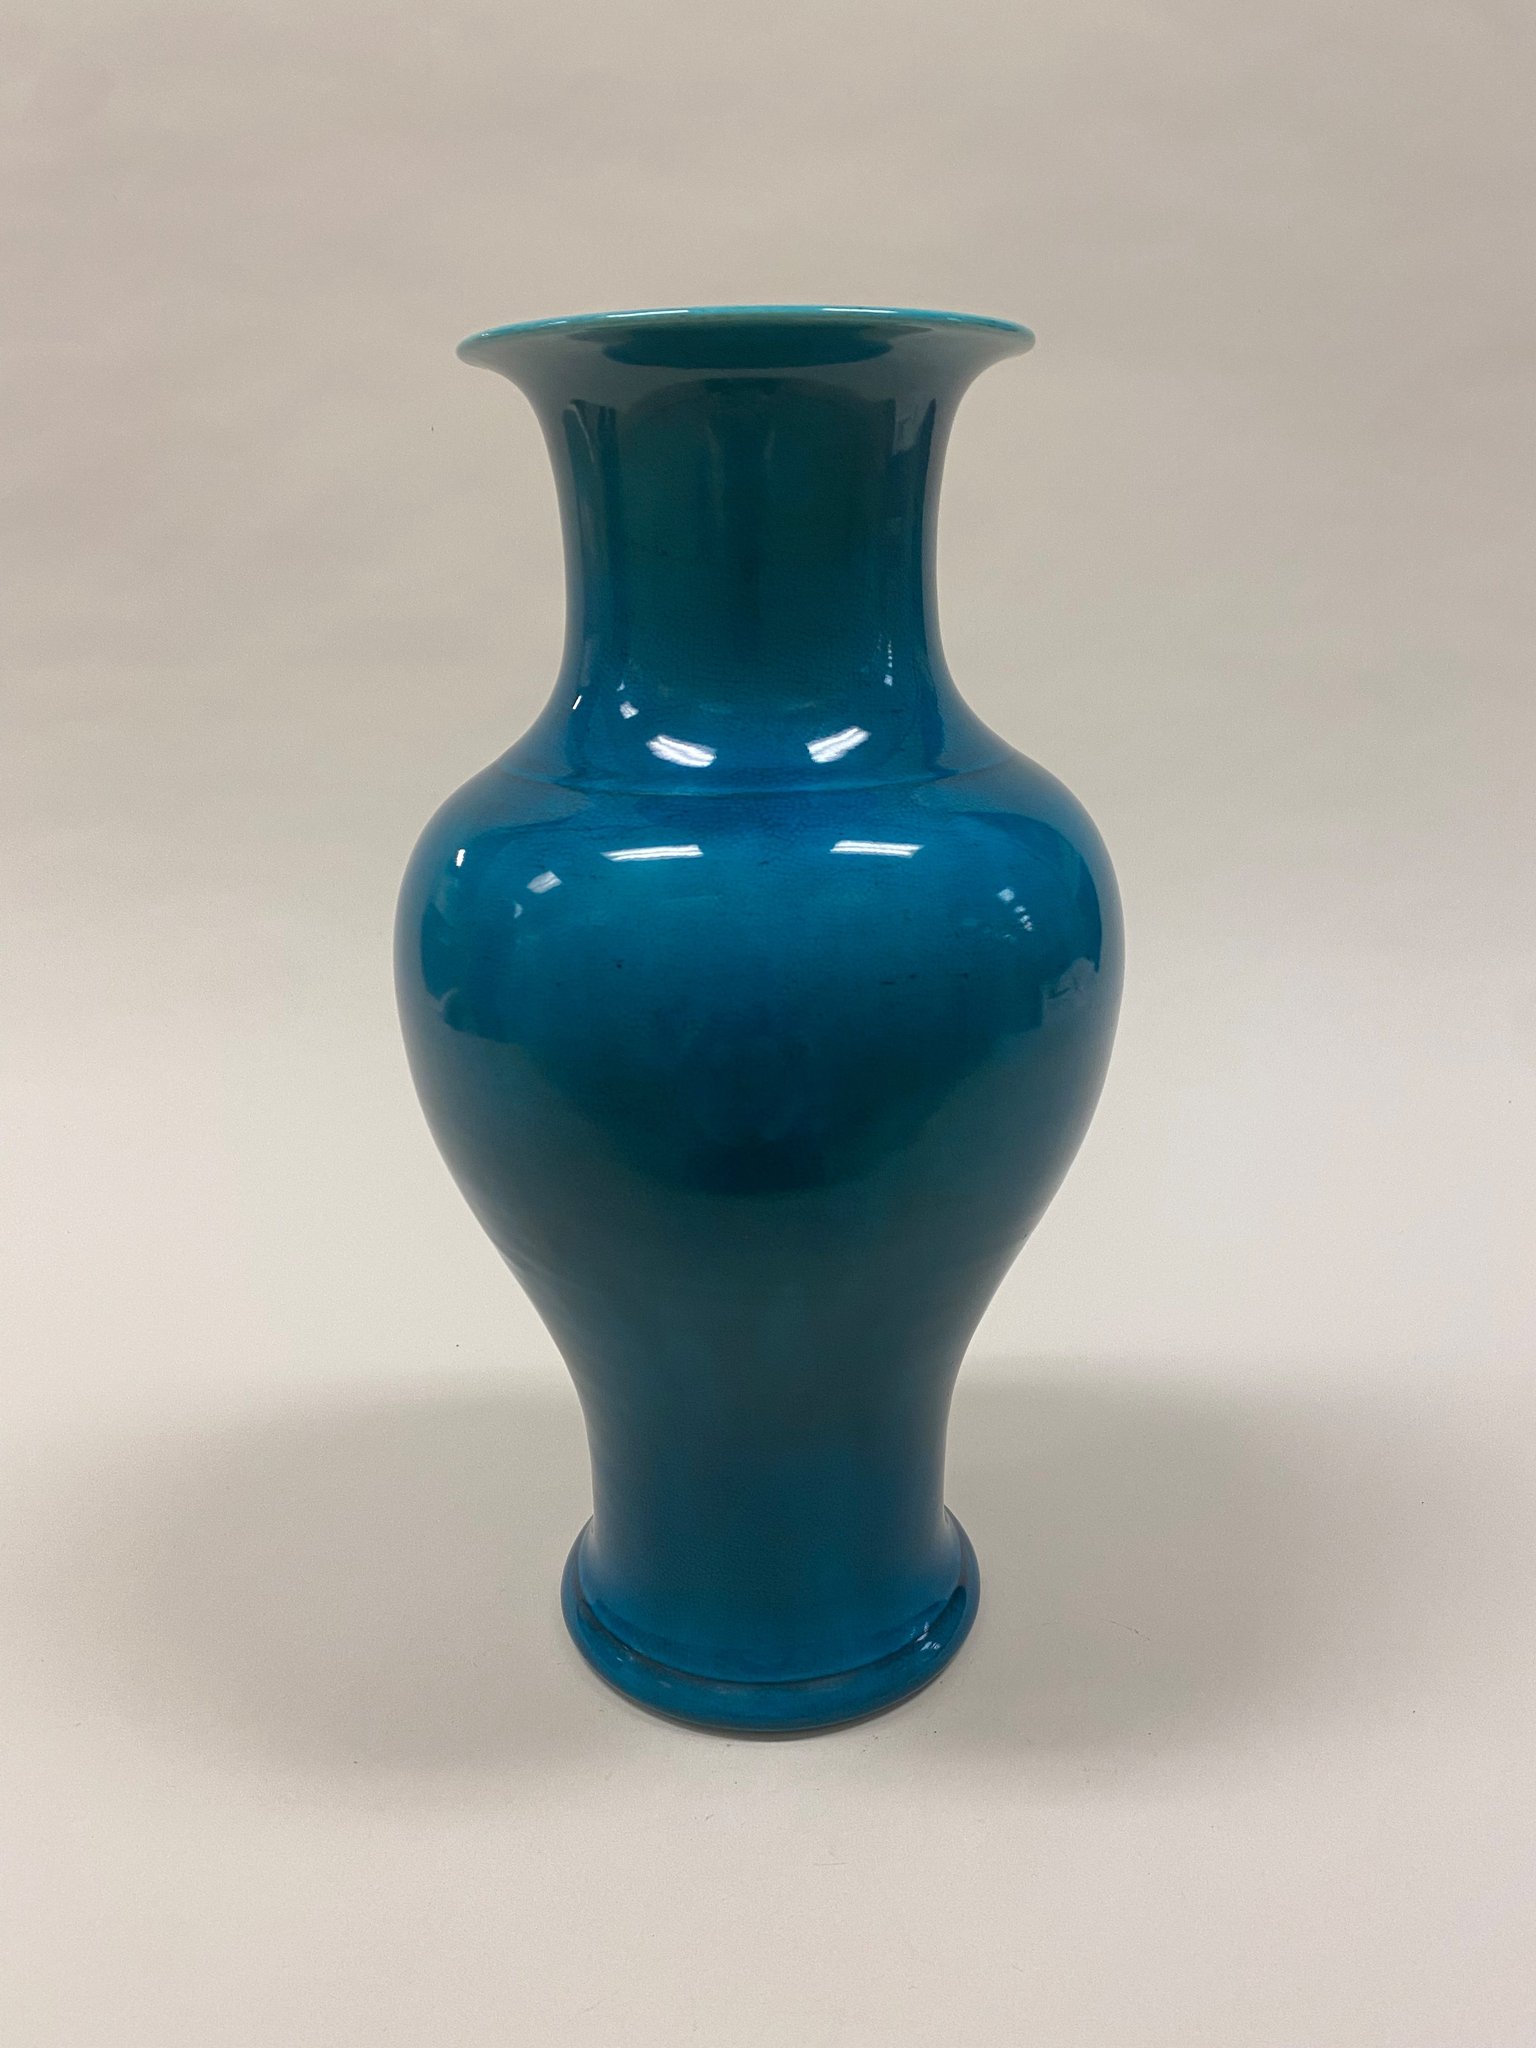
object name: vase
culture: chinese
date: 1701-1800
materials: glaze, porcelain